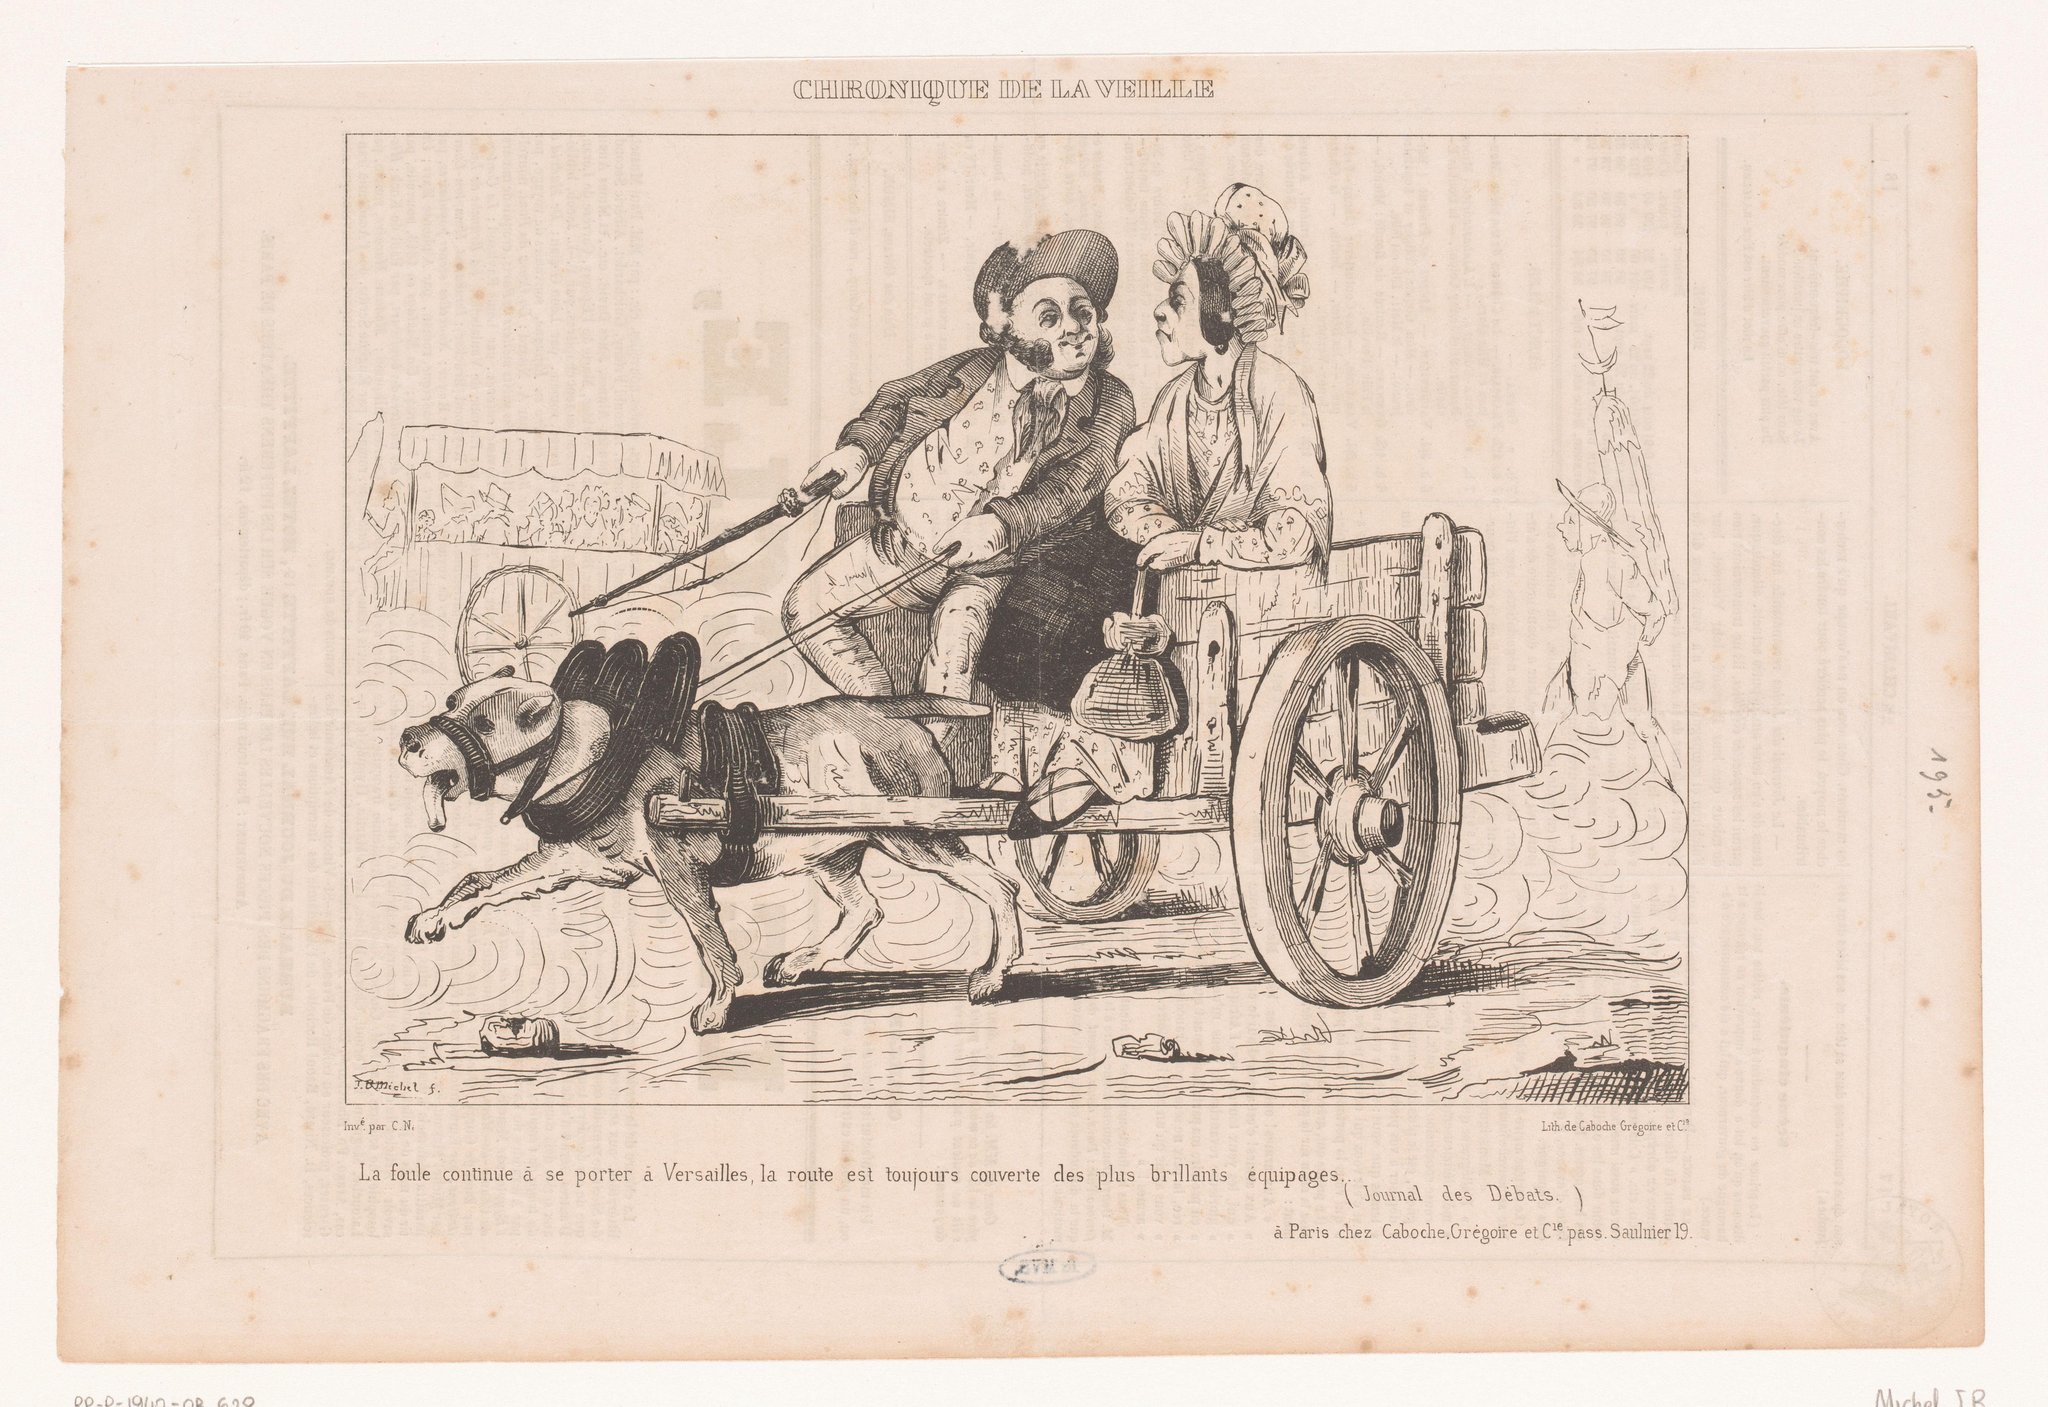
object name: cartoon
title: Verschil in transport in Frankrijk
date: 1837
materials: paper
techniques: letterpress printing, lithograph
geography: paris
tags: hand-cart, contrast between rich and poor, political caricatures and satires, dog, france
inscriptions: collector's mark: Lugt 2228, collector's mark: ‘Timbre Royal Seine’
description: Prent uit: Le Charivari 6 (1837), nr. 238, 14 september 1837.